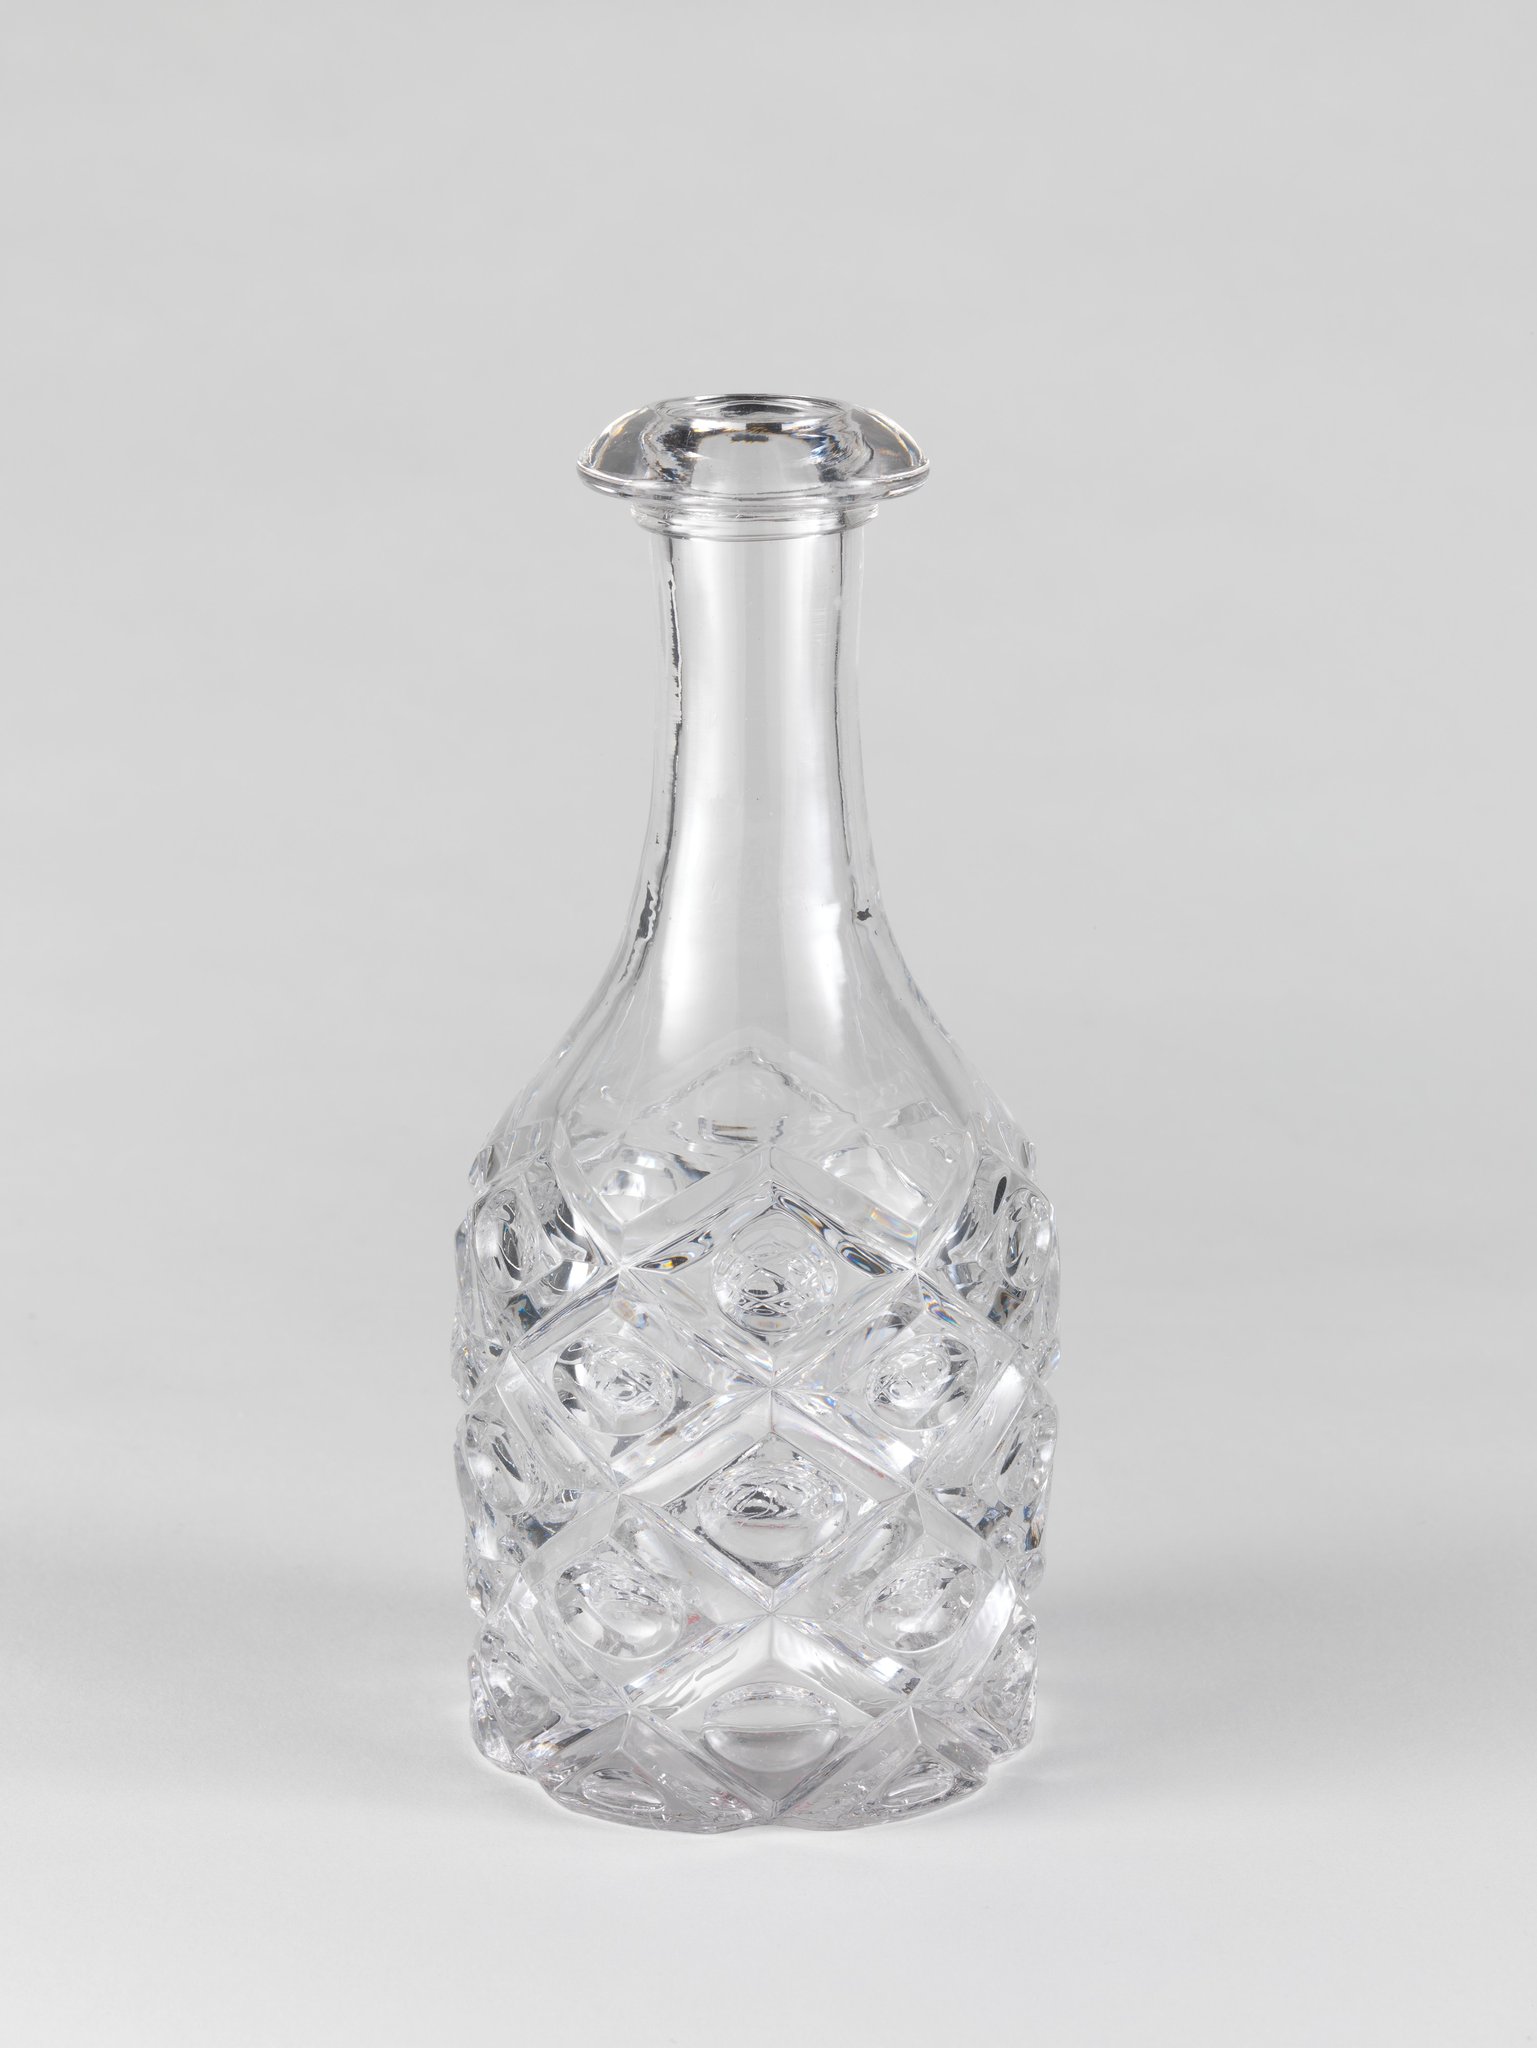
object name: pint decanter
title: Half-pint decanter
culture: american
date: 1850-1870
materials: diamond, glass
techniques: pressed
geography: united states